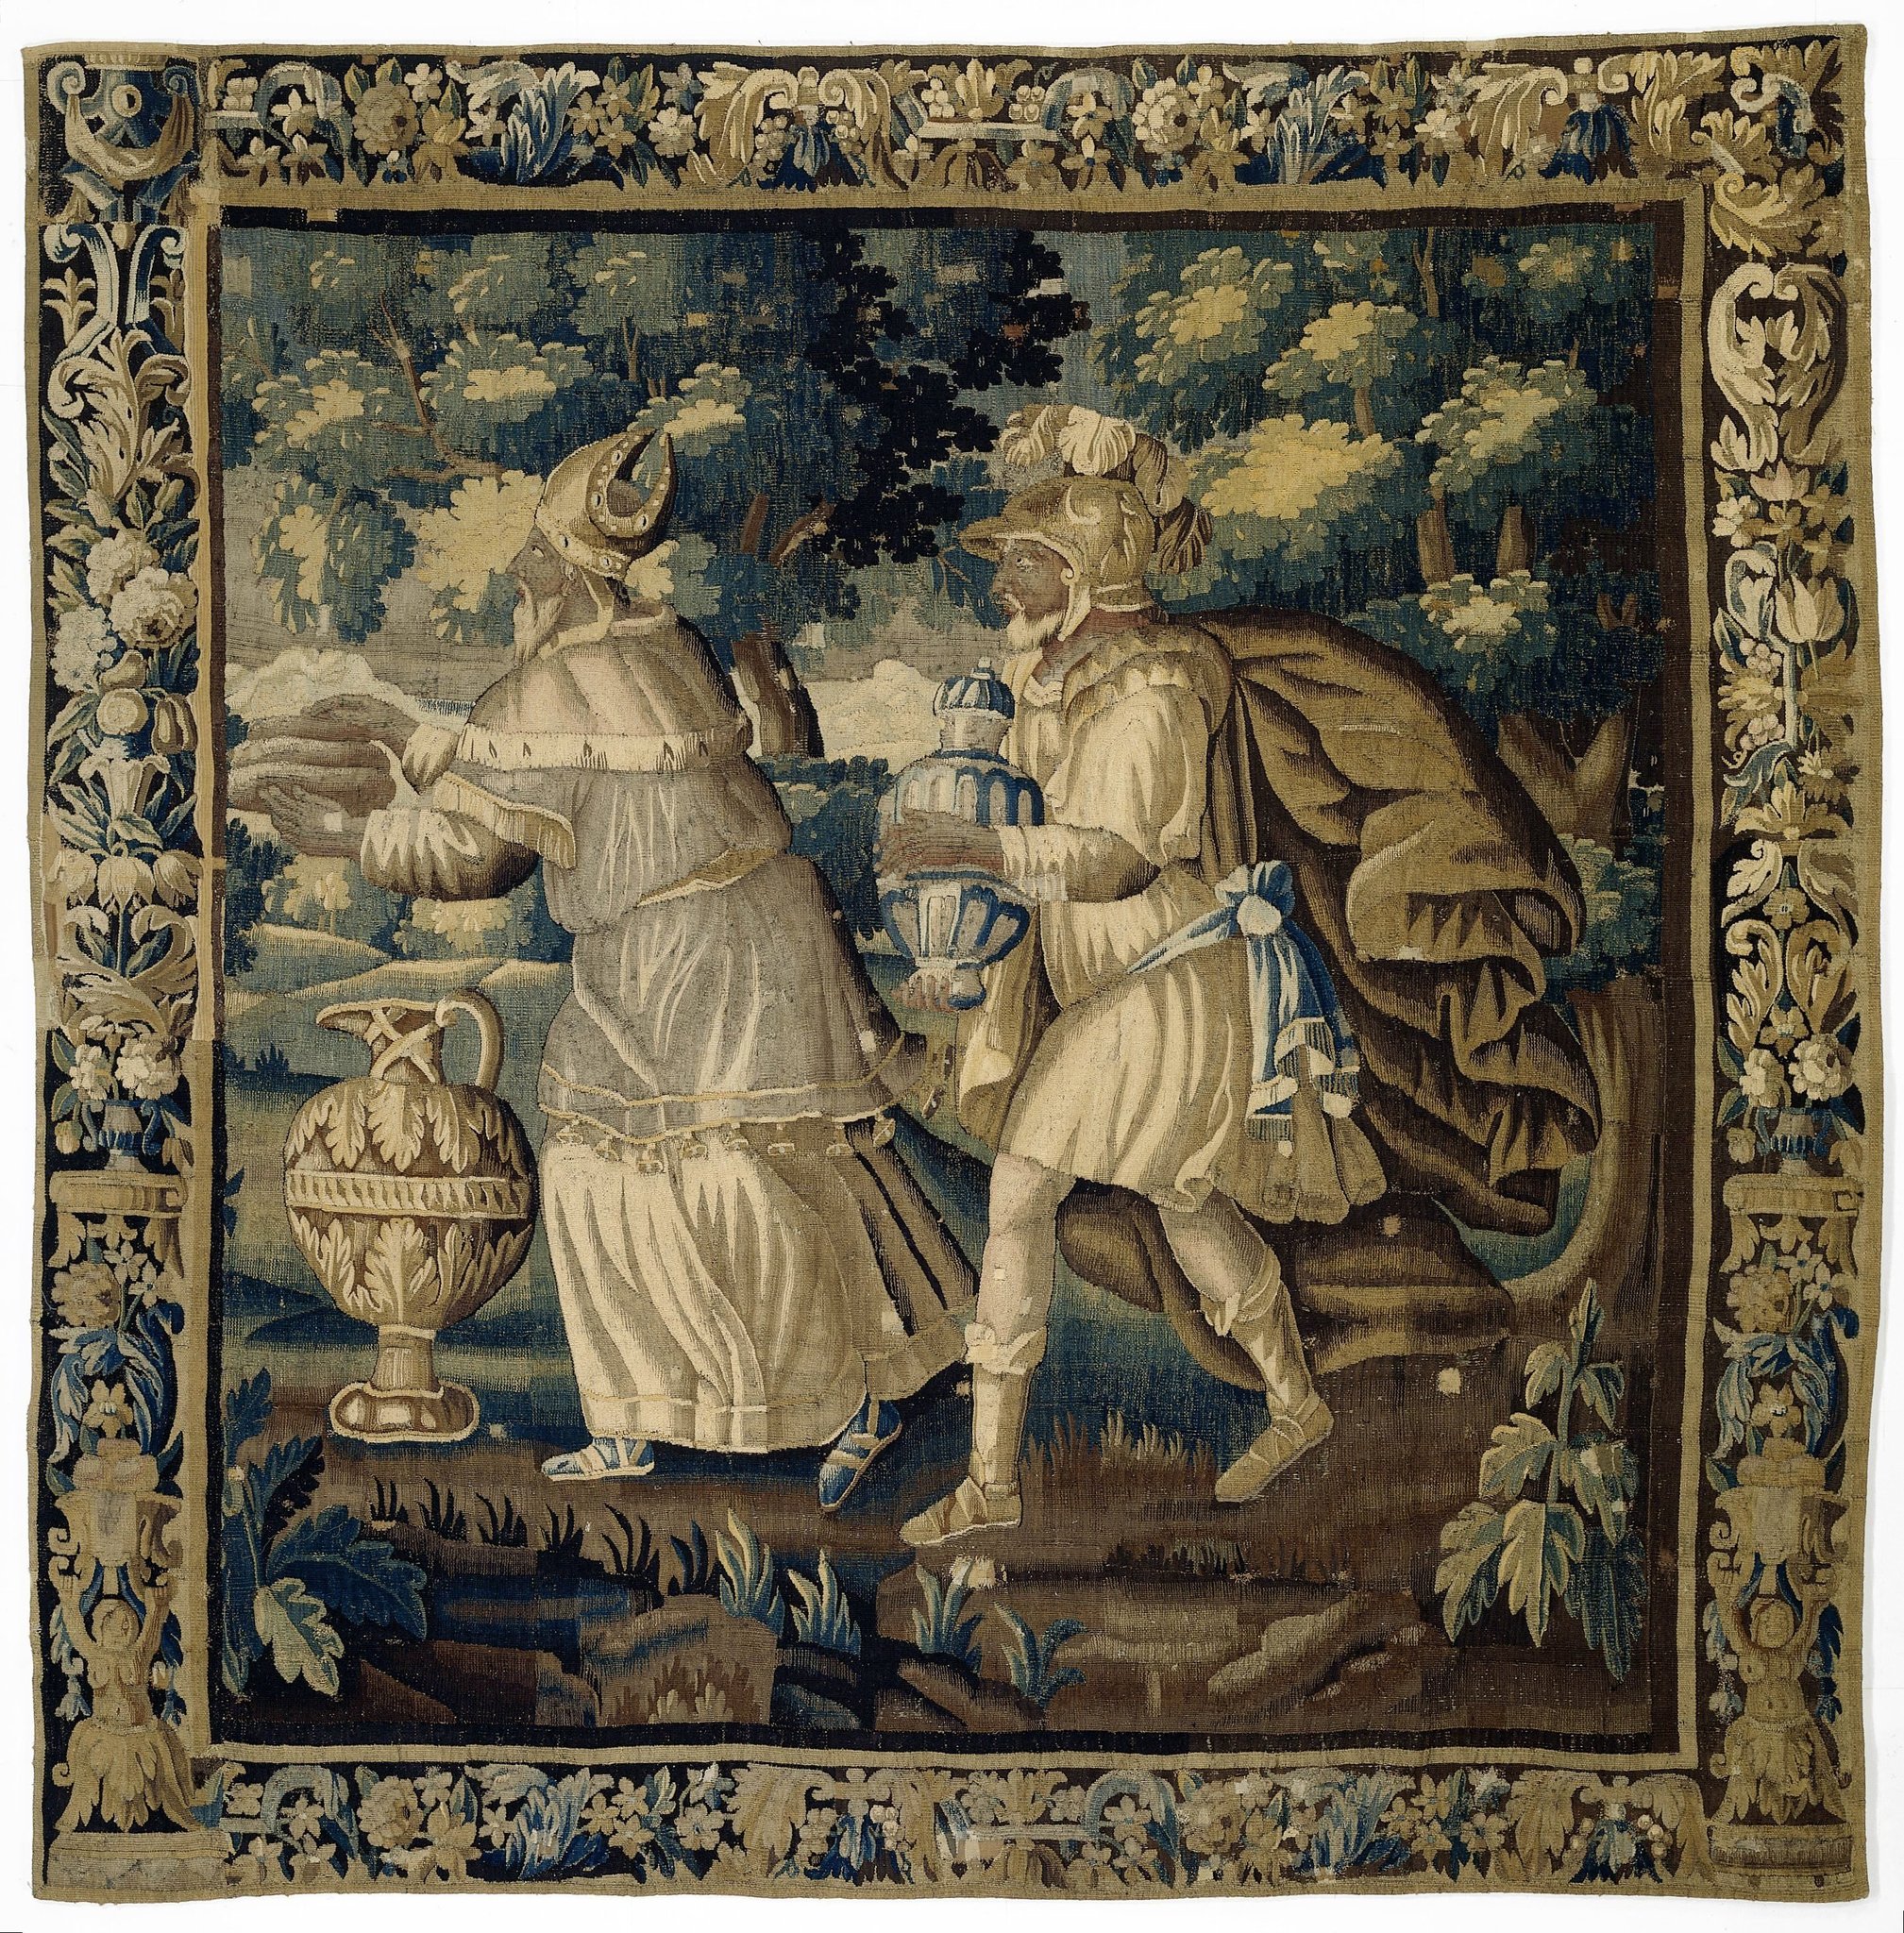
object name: tapestry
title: Melchisedek brengt brood en wijn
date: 1660-1690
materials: silk, wool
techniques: tapestry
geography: aubusson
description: Wandtapijt met fragment van een voorstelling van Melchisedek die toonbroden en wijn aan Abraham aanbiedt.